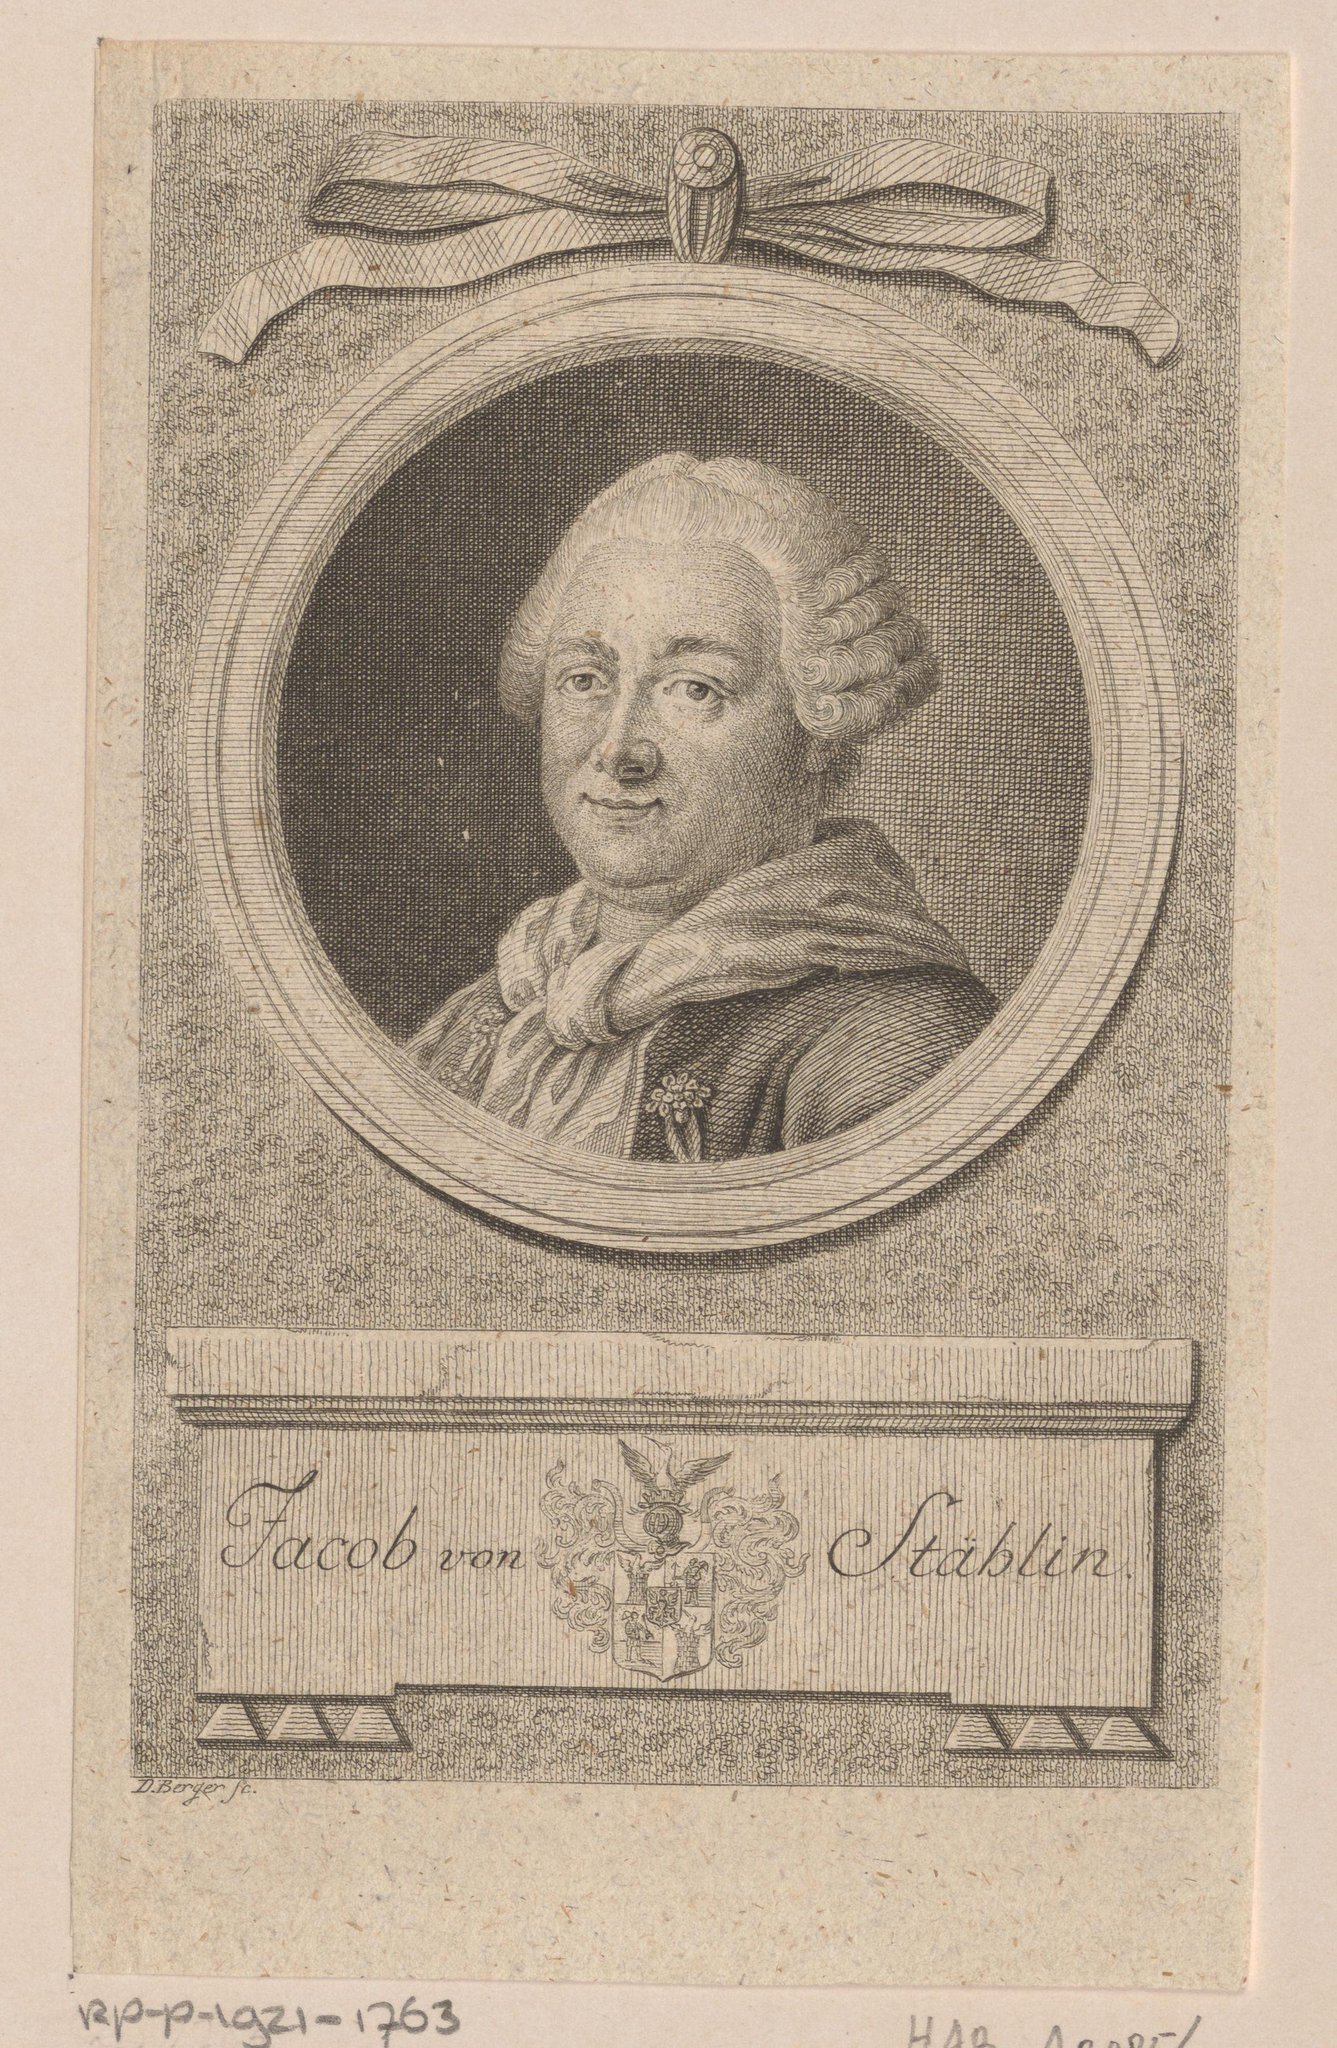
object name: print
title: Portret van Jacob von Stählin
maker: daniel berger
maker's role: print maker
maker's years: 1744-1824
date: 1777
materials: paper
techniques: engraving, etching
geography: berlin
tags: historical persons, portrait of a writer, armorial bearing, heraldry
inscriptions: collector's mark: Lugt 2233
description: Prent waarschijnlijk uit: Krünitz, Johann Georg. Oeconomische Encyclopädie. dl. 10. Berlijn: Joachim Pauli, 1777.